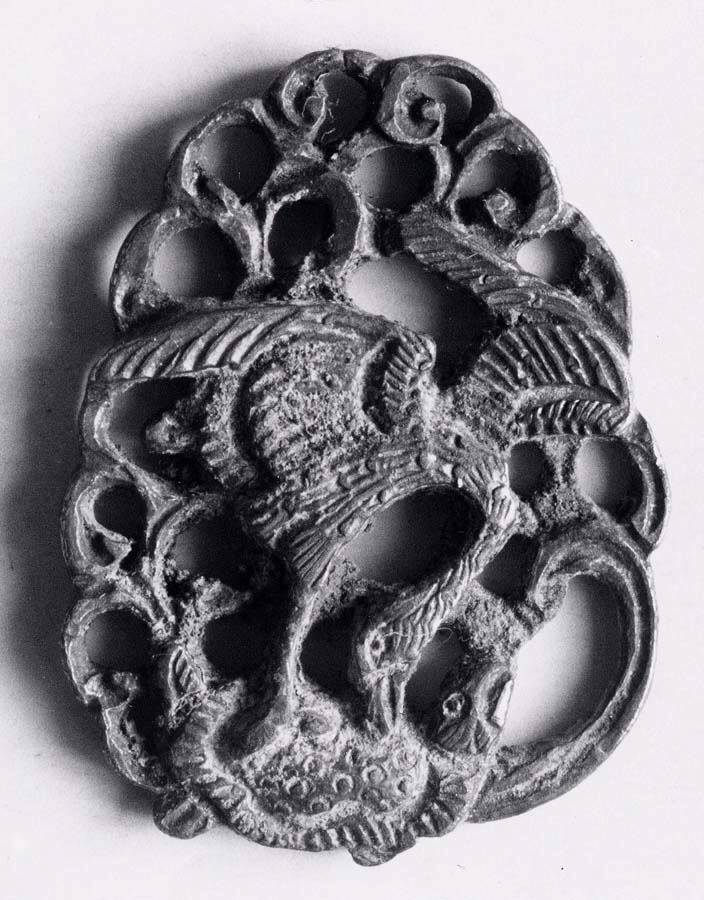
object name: ornament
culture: korean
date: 918-1392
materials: silver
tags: birds,turtles